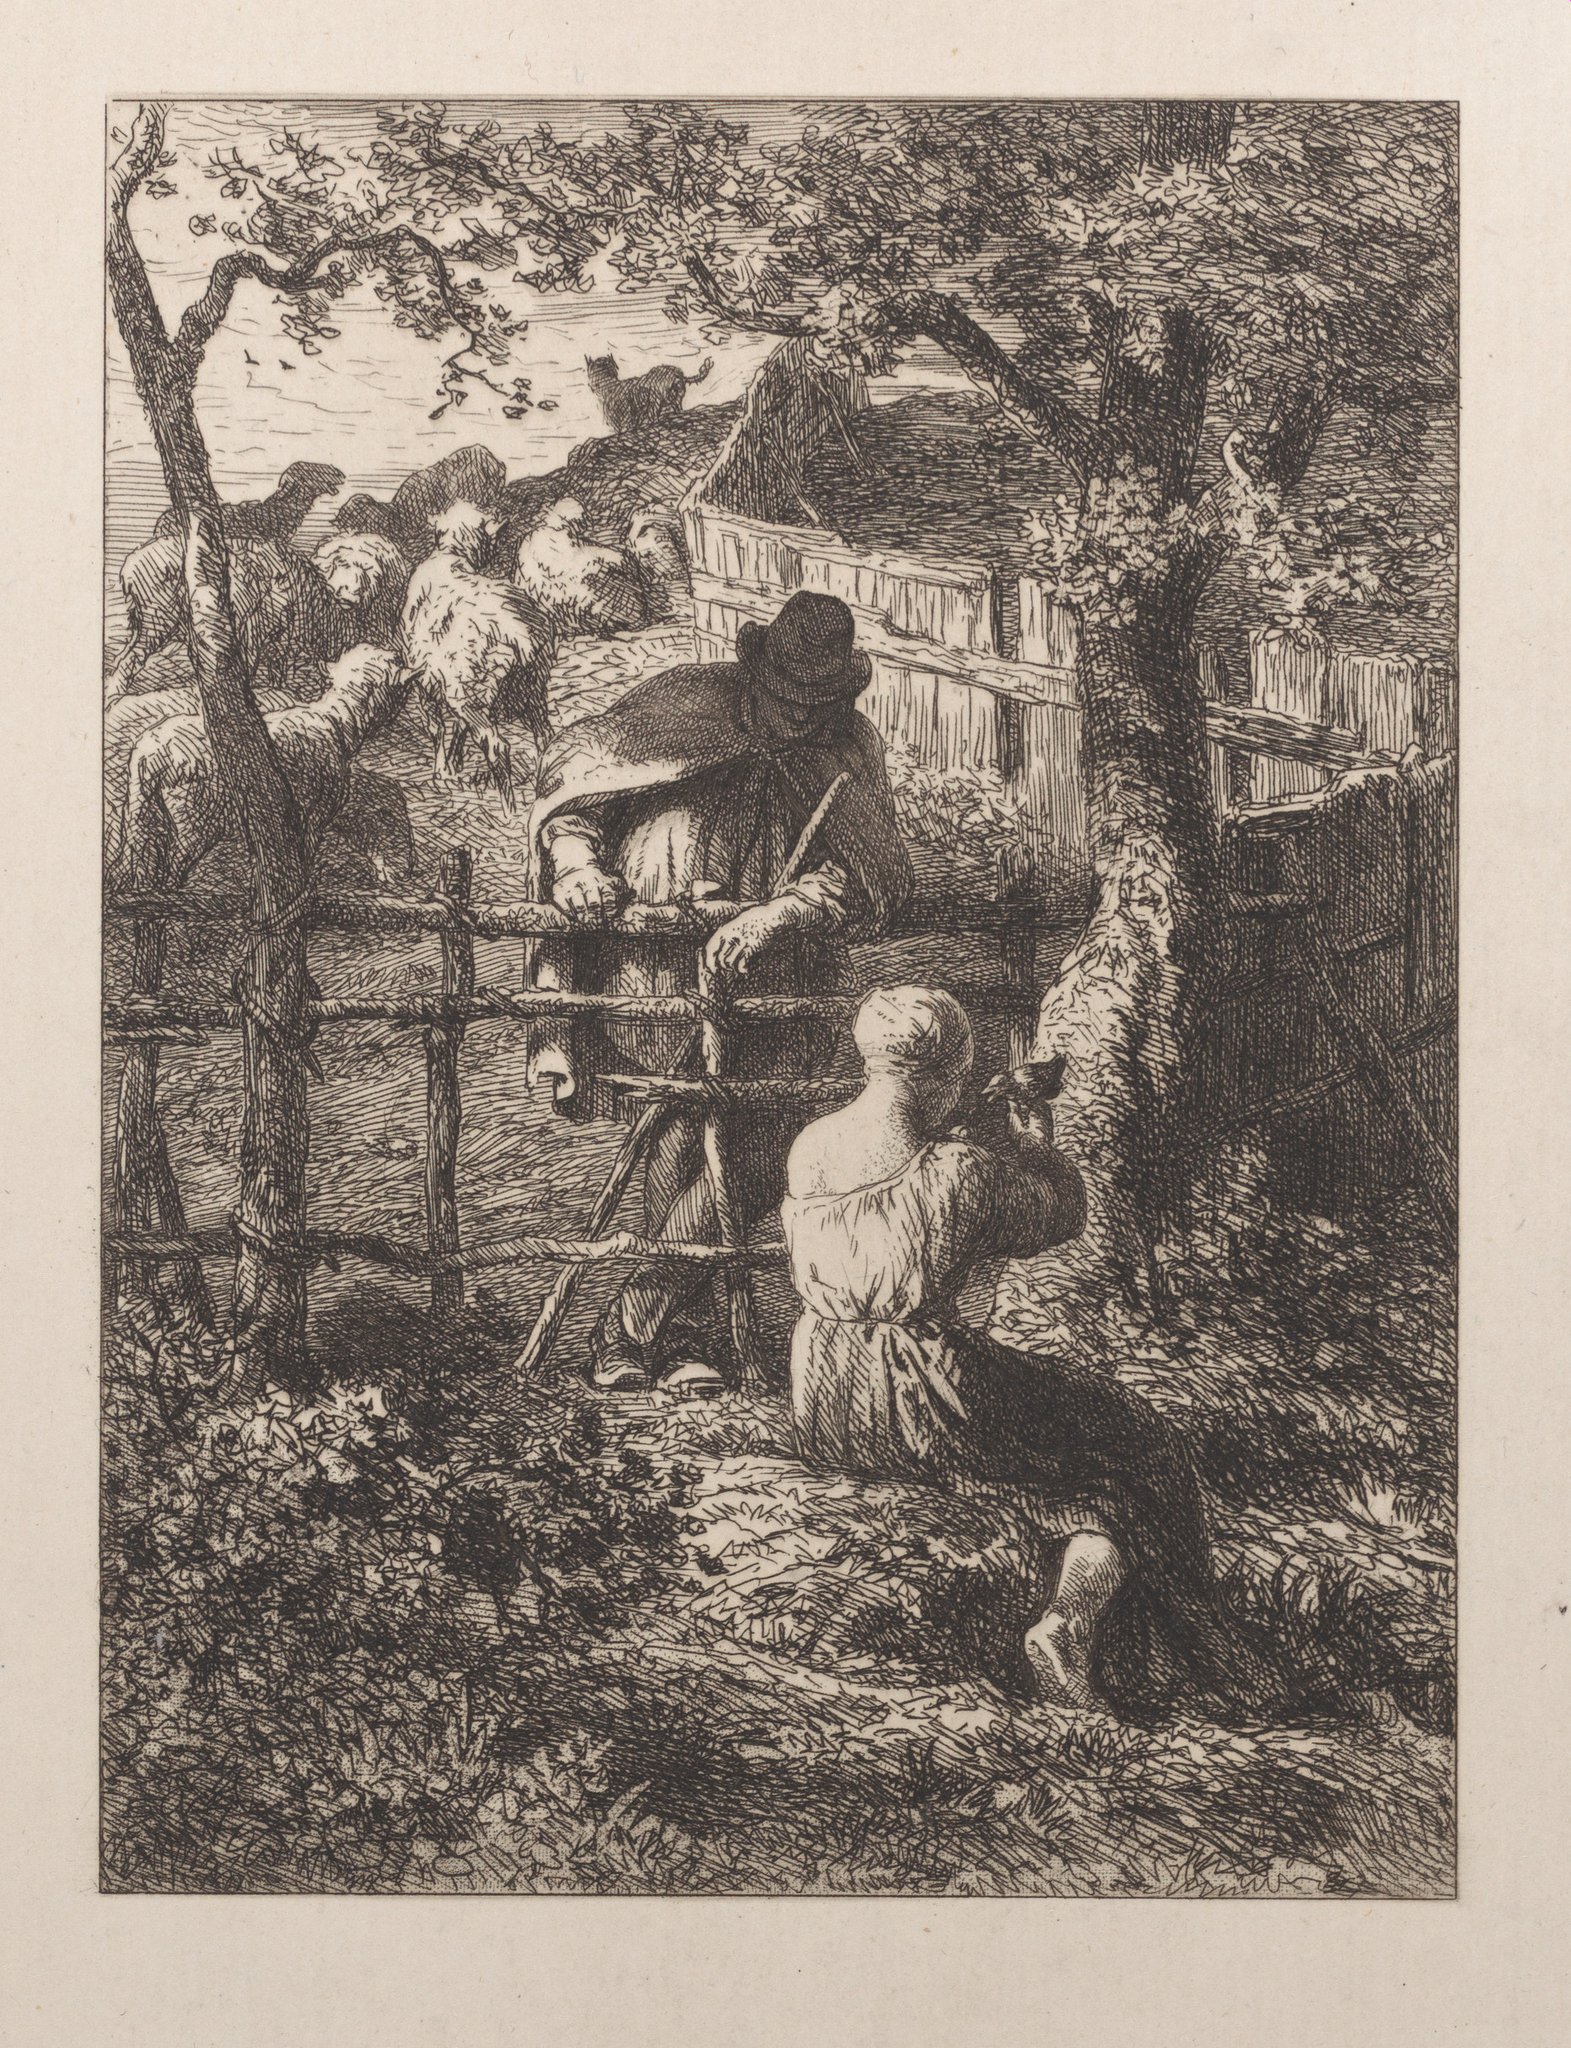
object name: print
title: Summer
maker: charles émile jacque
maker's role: artist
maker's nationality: french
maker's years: 1813-1894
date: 1864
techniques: etching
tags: men,women,sheep